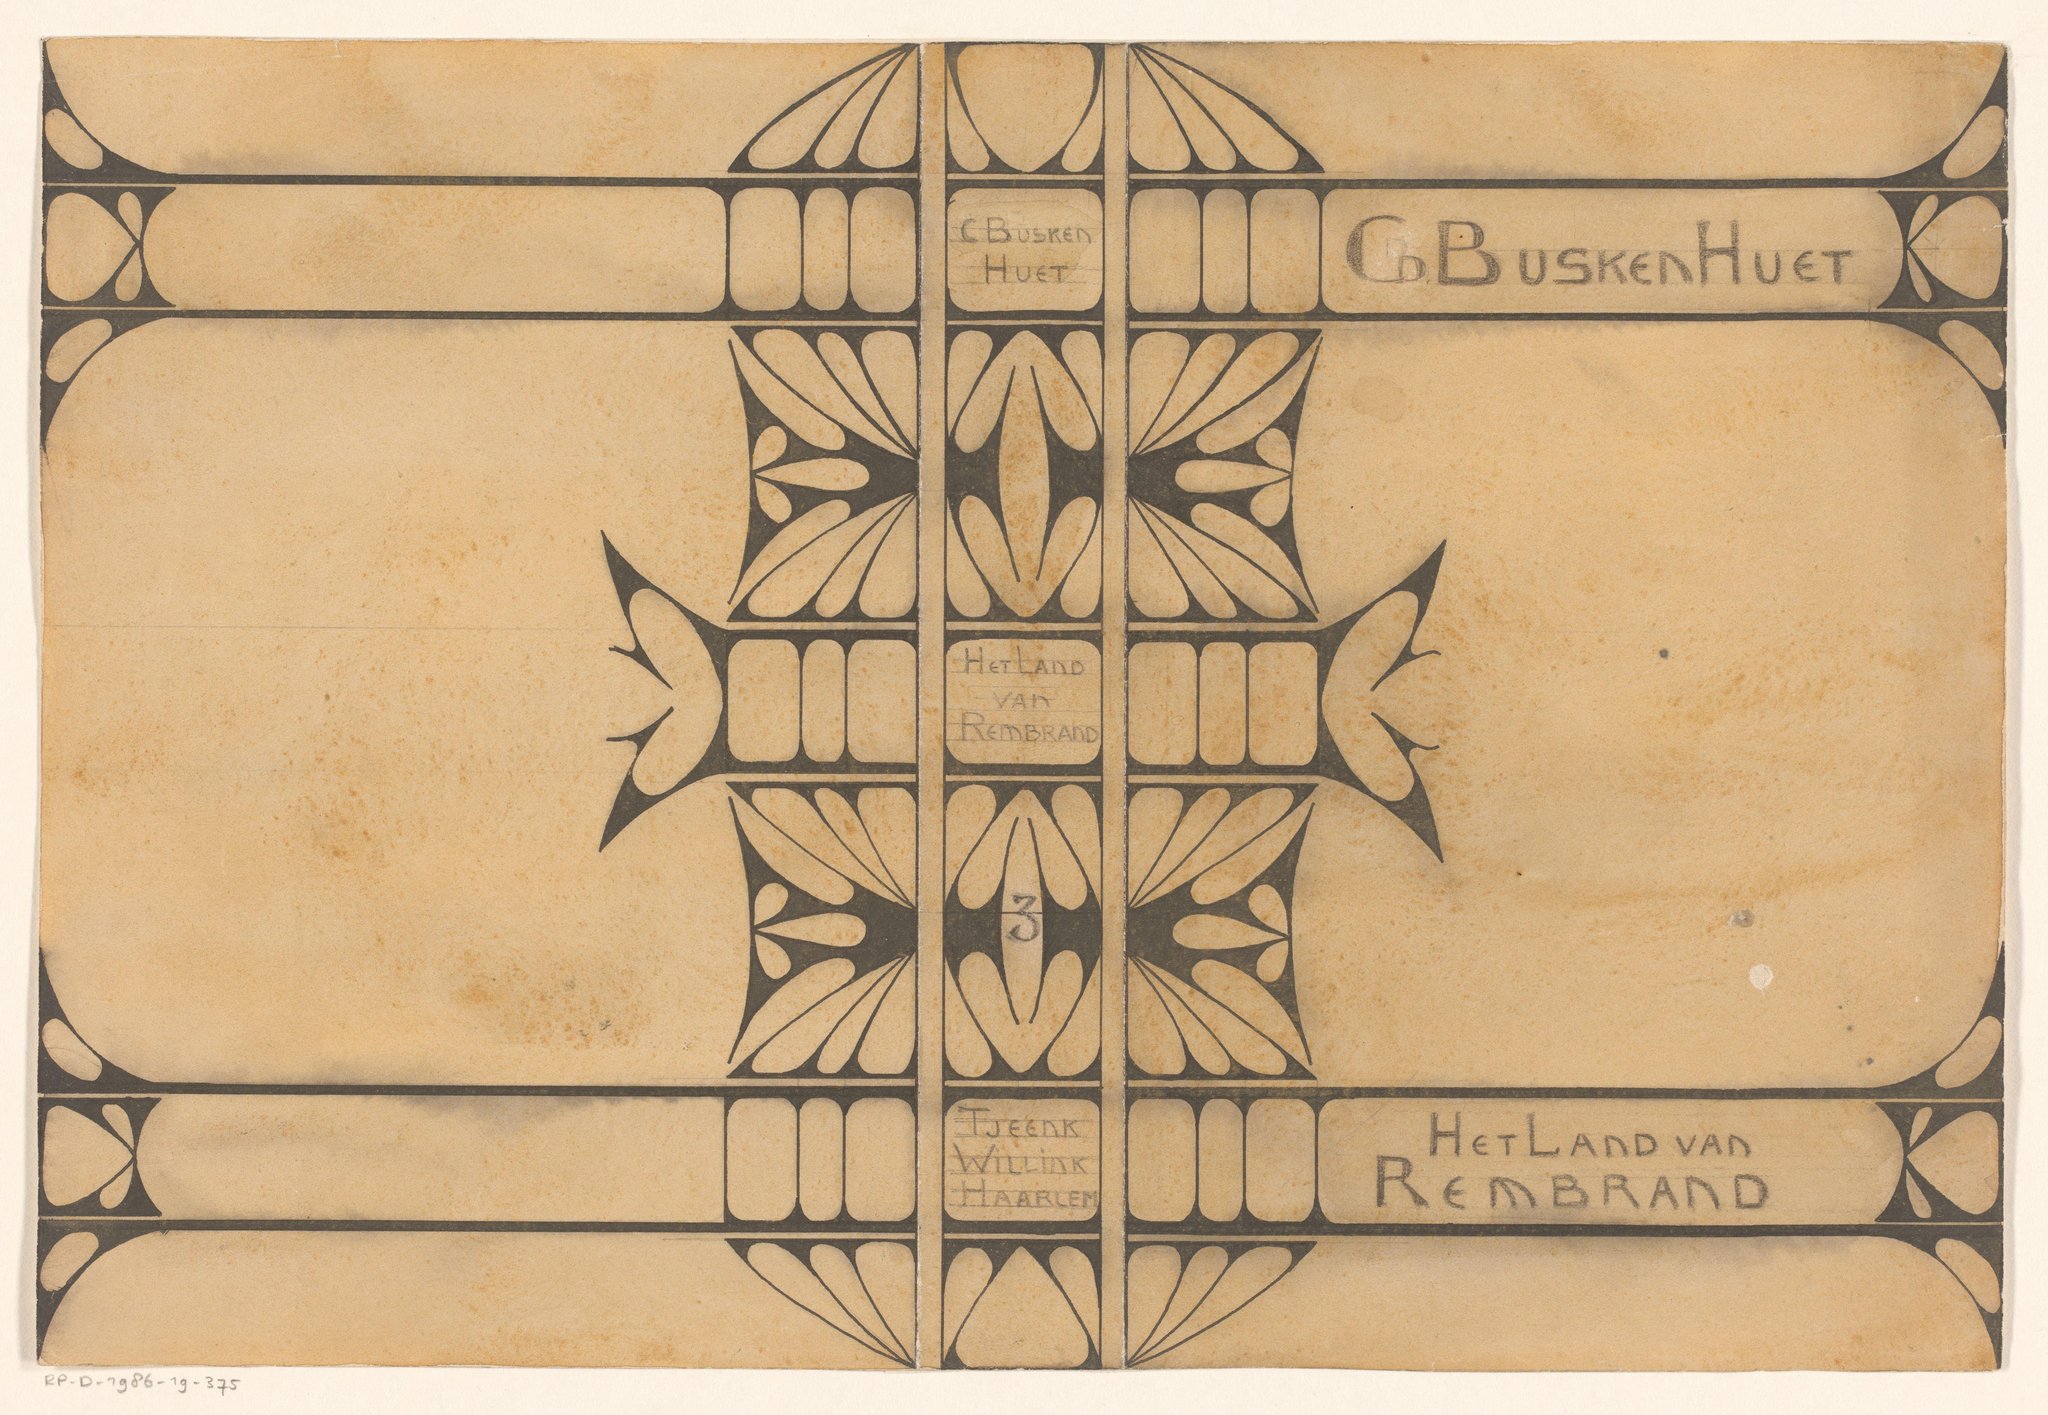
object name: drawing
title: Bandontwerp voor: Cd. Busken Huet, Het land van Rembrand, 1898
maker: reinier willem petrus de vries (1874-1953)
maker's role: draughtsman, print maker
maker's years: 1874-1953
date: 1898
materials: chalk, paint, ink, paper, pencil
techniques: brush, pen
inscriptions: collector's mark: ‘R:MVS.’, inscription: ‘C.B./ C.B./ C.B.’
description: Ontwerp voor: Busken Huet, Cd. Het land van Rembrand. Haarlem: Tjeenk Willink, 1898.